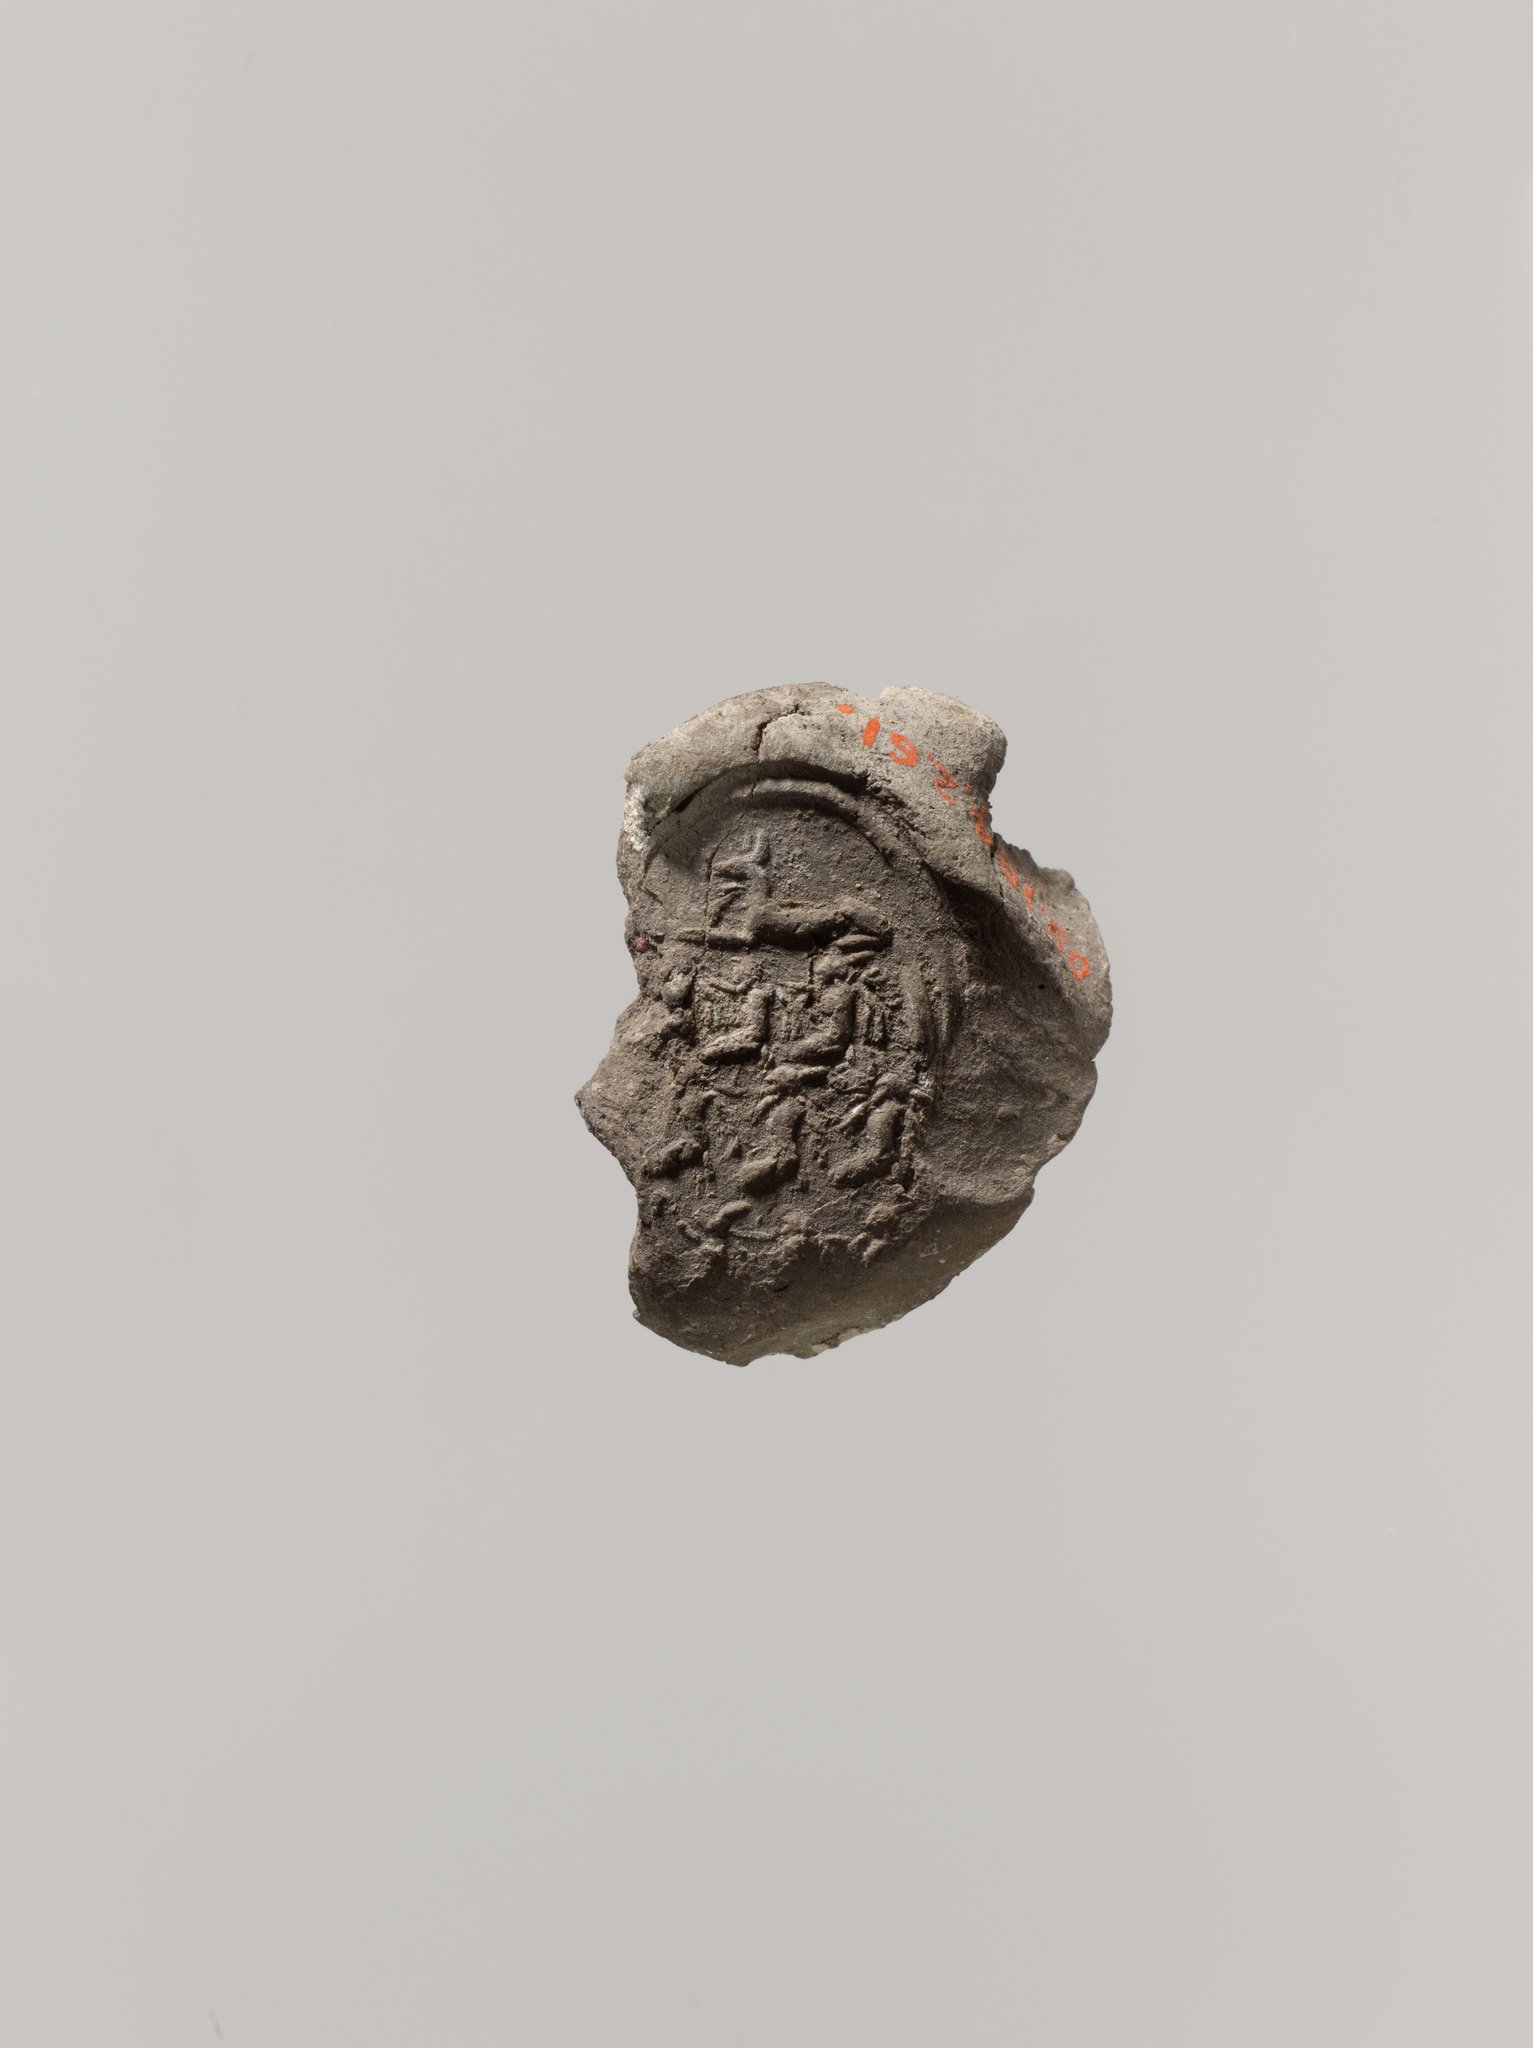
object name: sealing, necropolis seal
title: Fragmentary Impression of the Necropolis Seal from Tutankhamun's Embalming Cache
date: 1336-1327 BCE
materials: mud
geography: egypt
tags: human figures,jackals